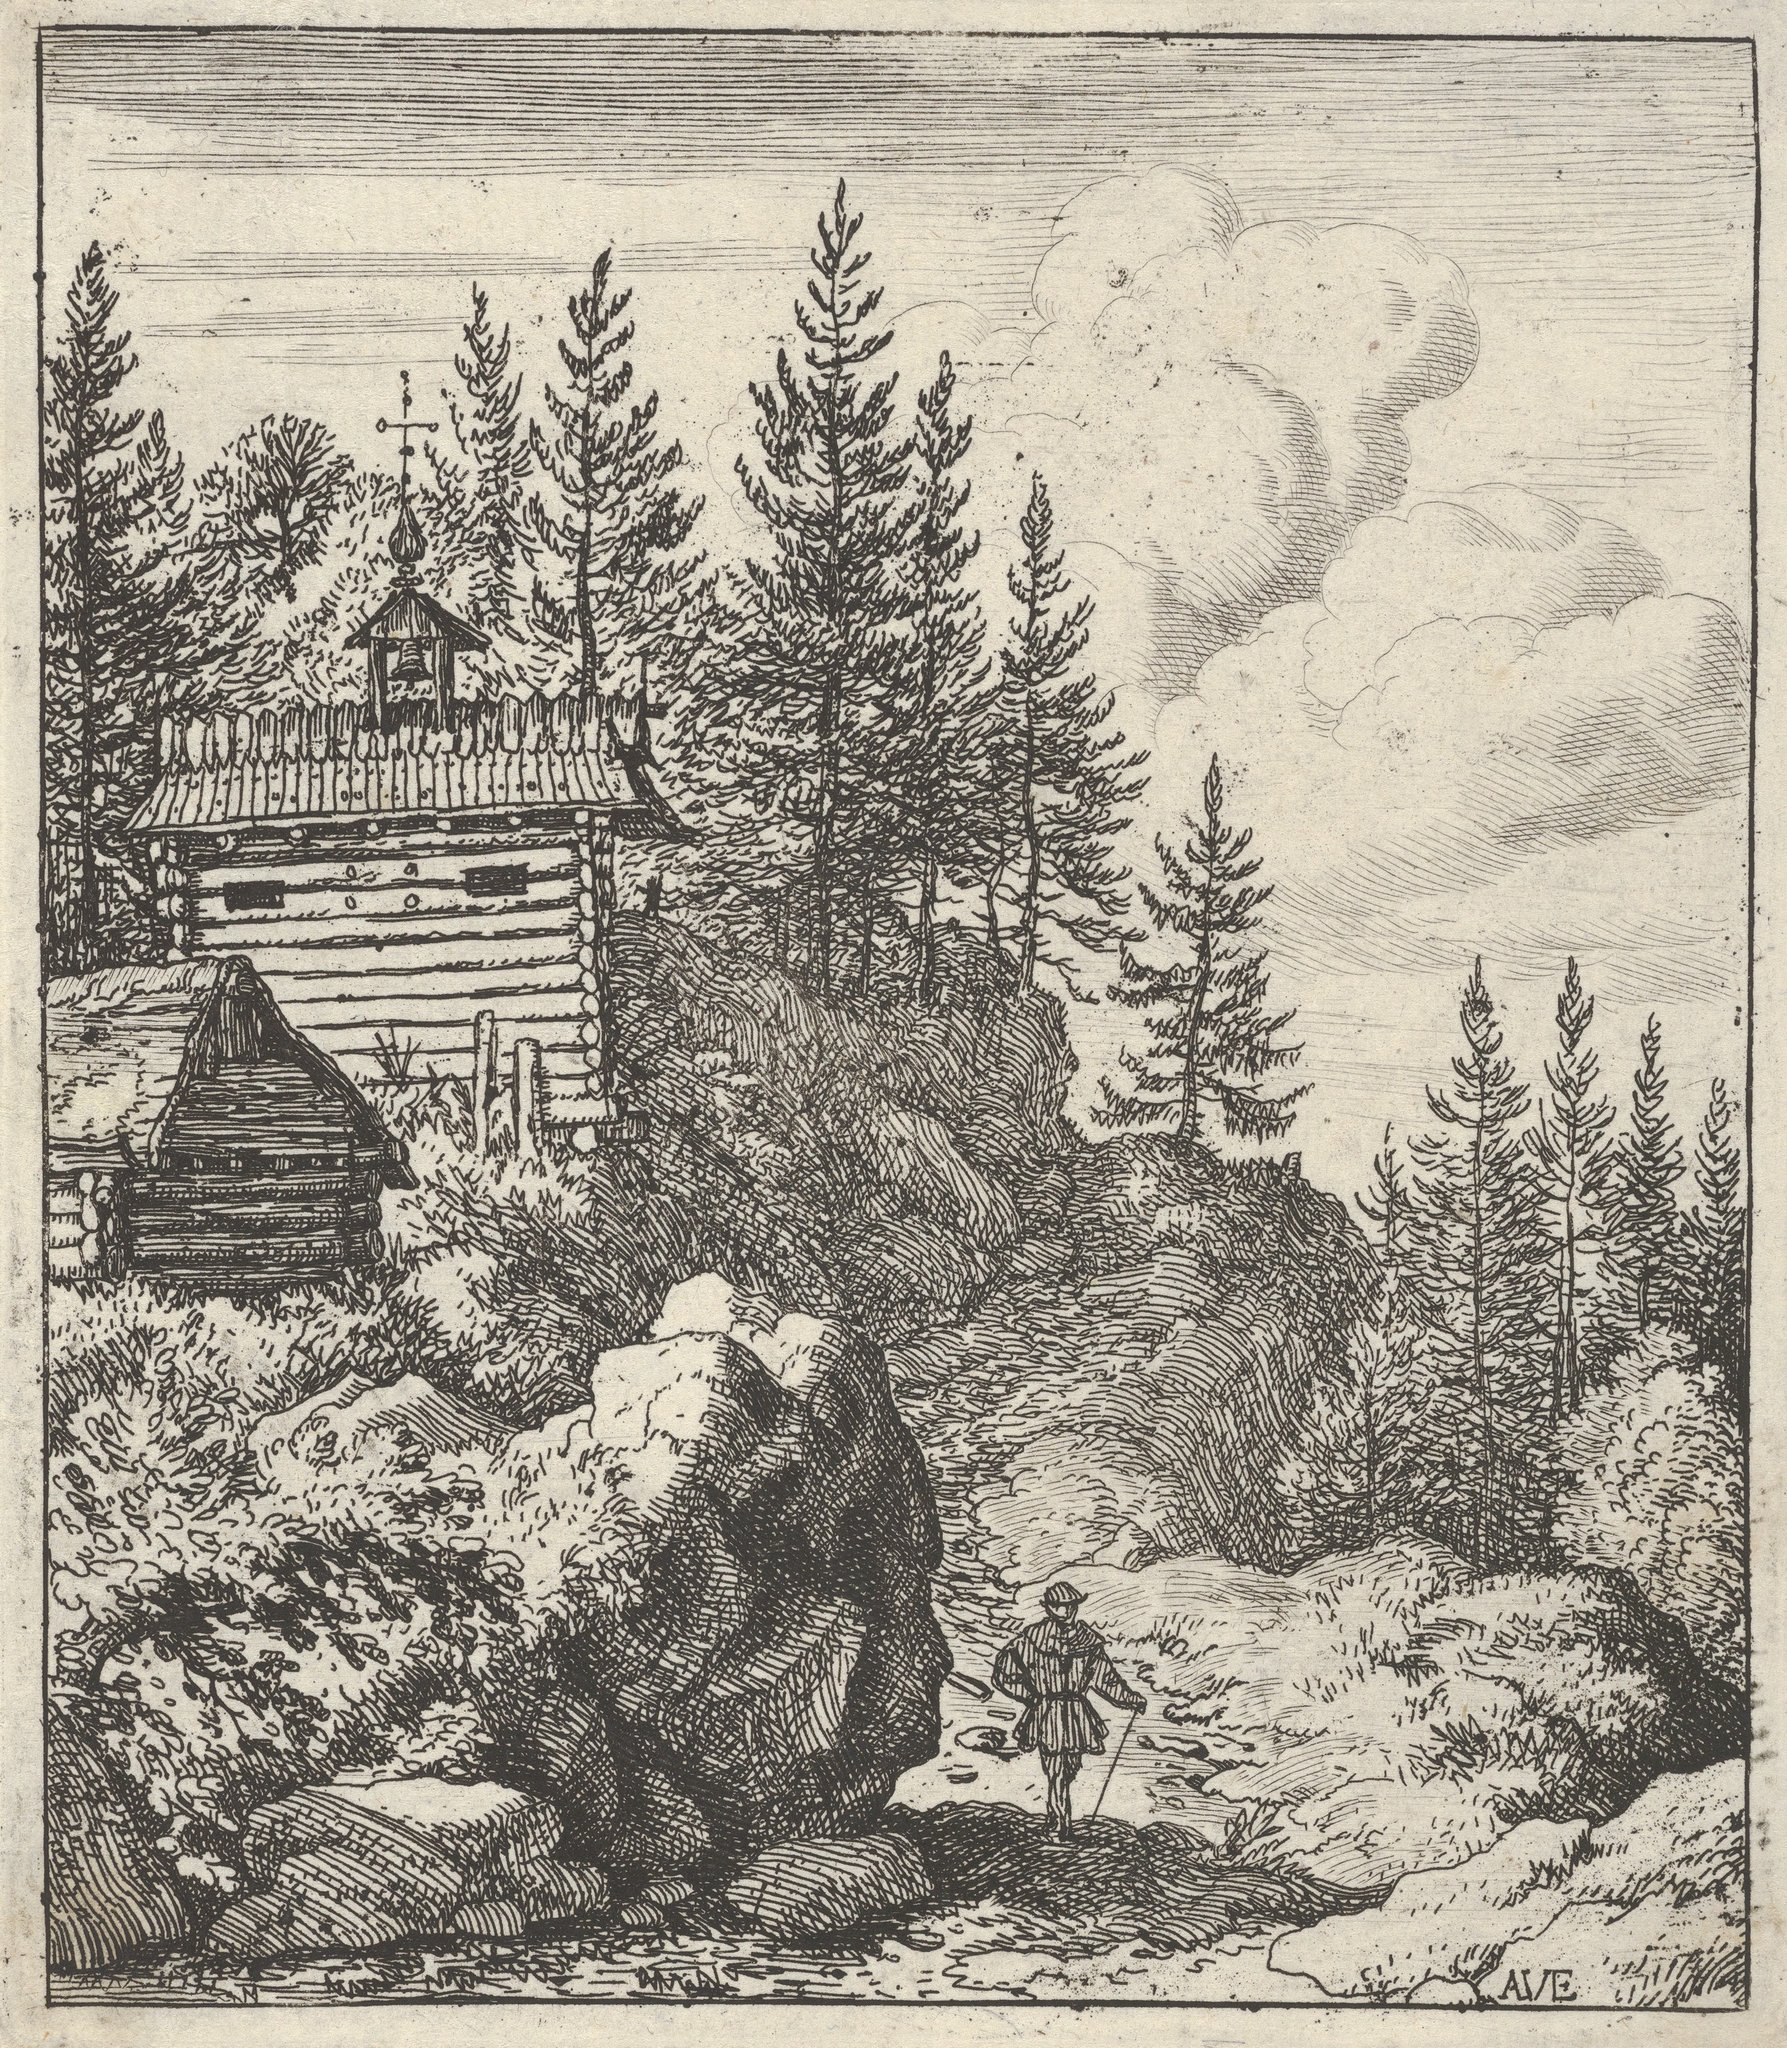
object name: print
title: The Chapel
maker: allart van everdingen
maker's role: artist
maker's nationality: dutch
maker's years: 1621-1675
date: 1621-1675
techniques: engraving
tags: roads,men,trees